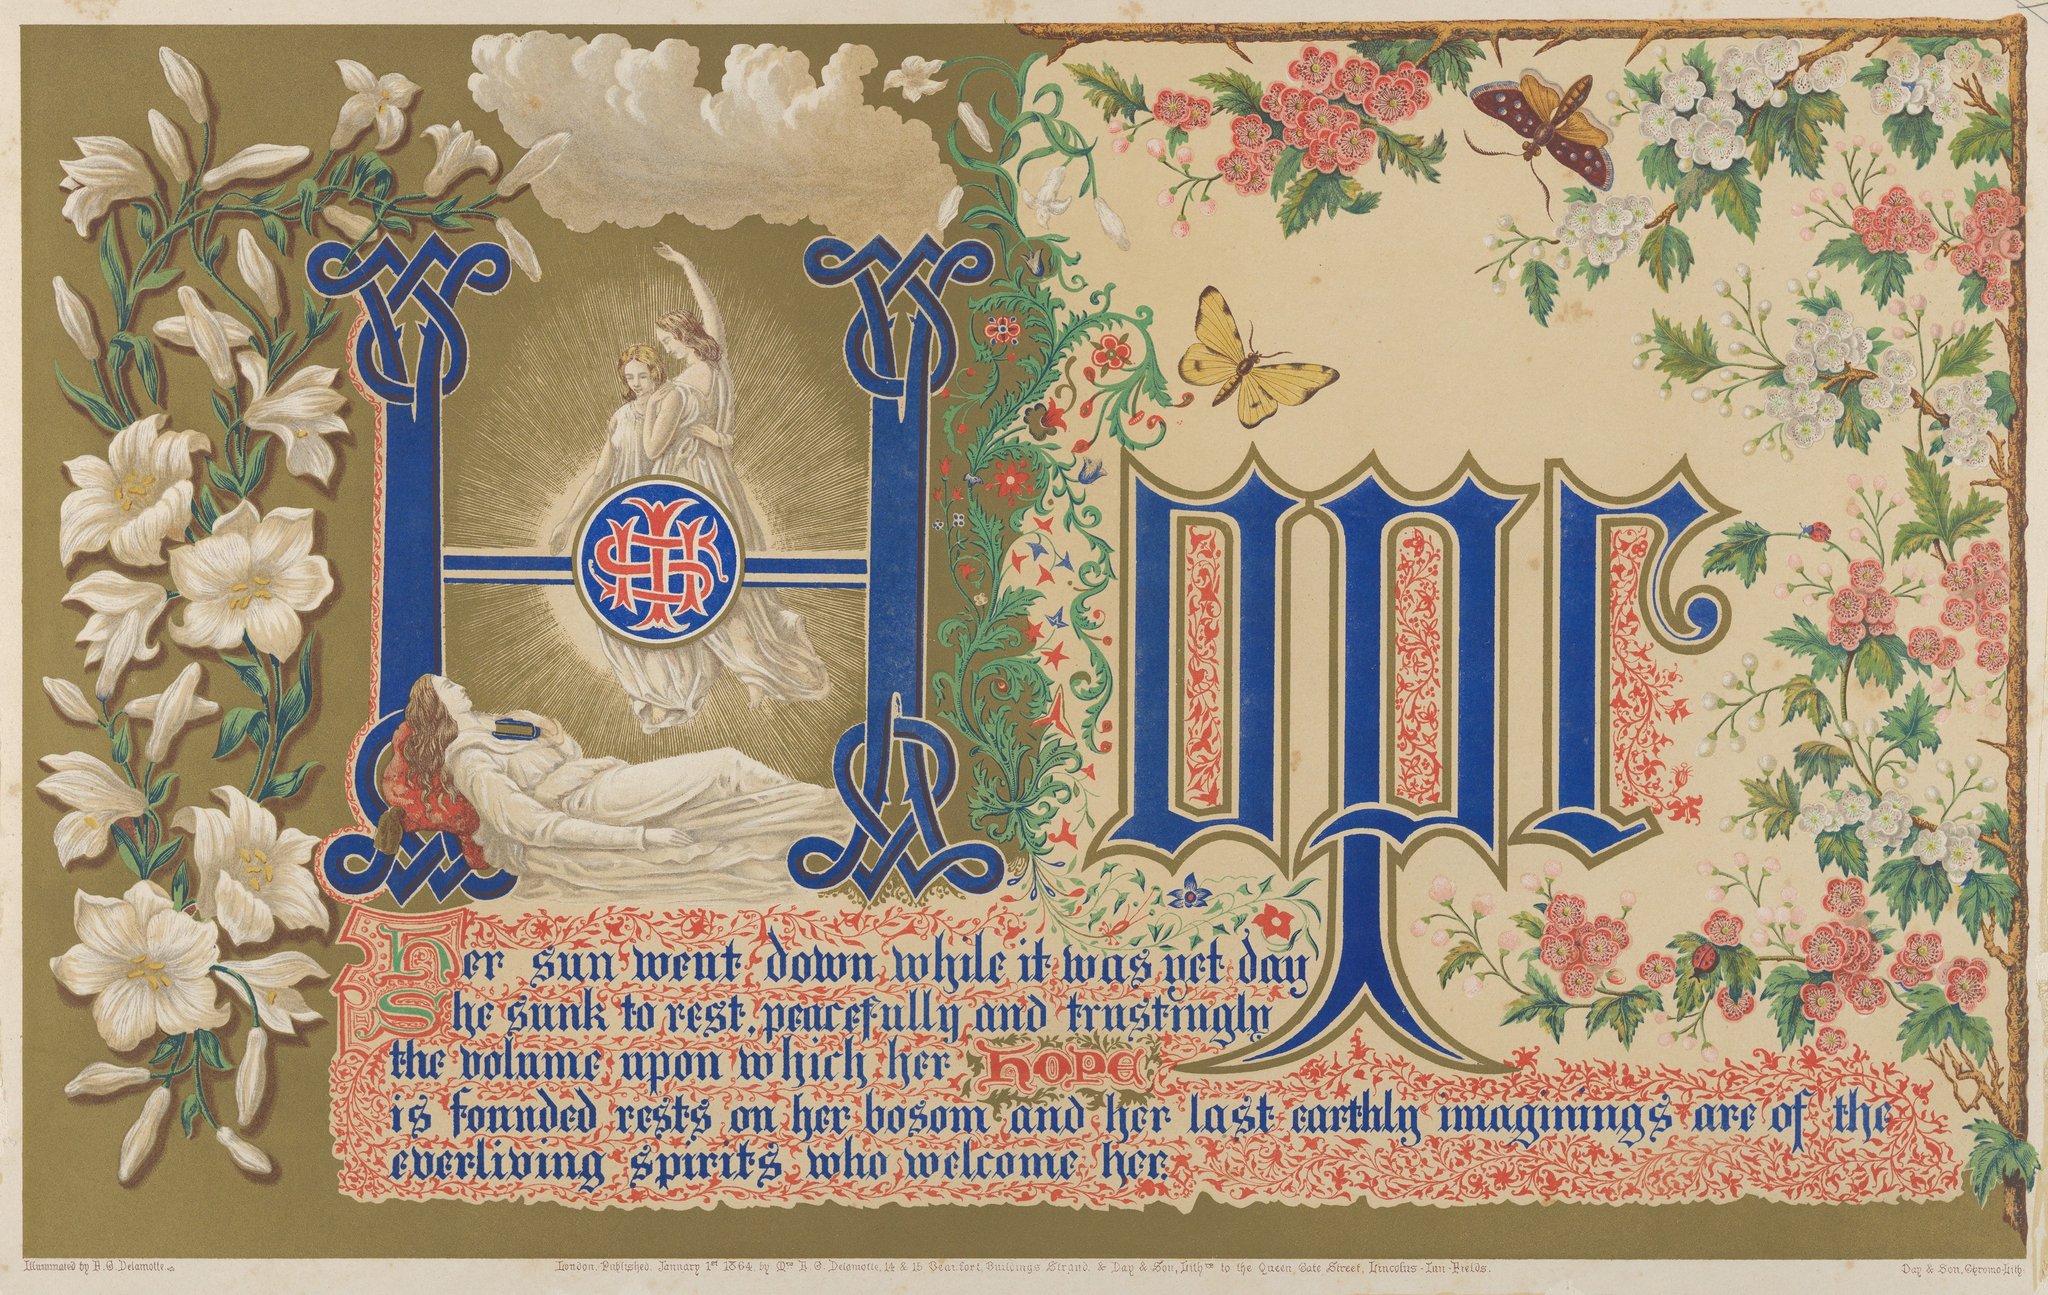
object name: print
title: Hope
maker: freeman gage delamotte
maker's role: artist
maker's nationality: british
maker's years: 1813-1862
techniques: lithograph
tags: women,butterflies,flowers,leaves